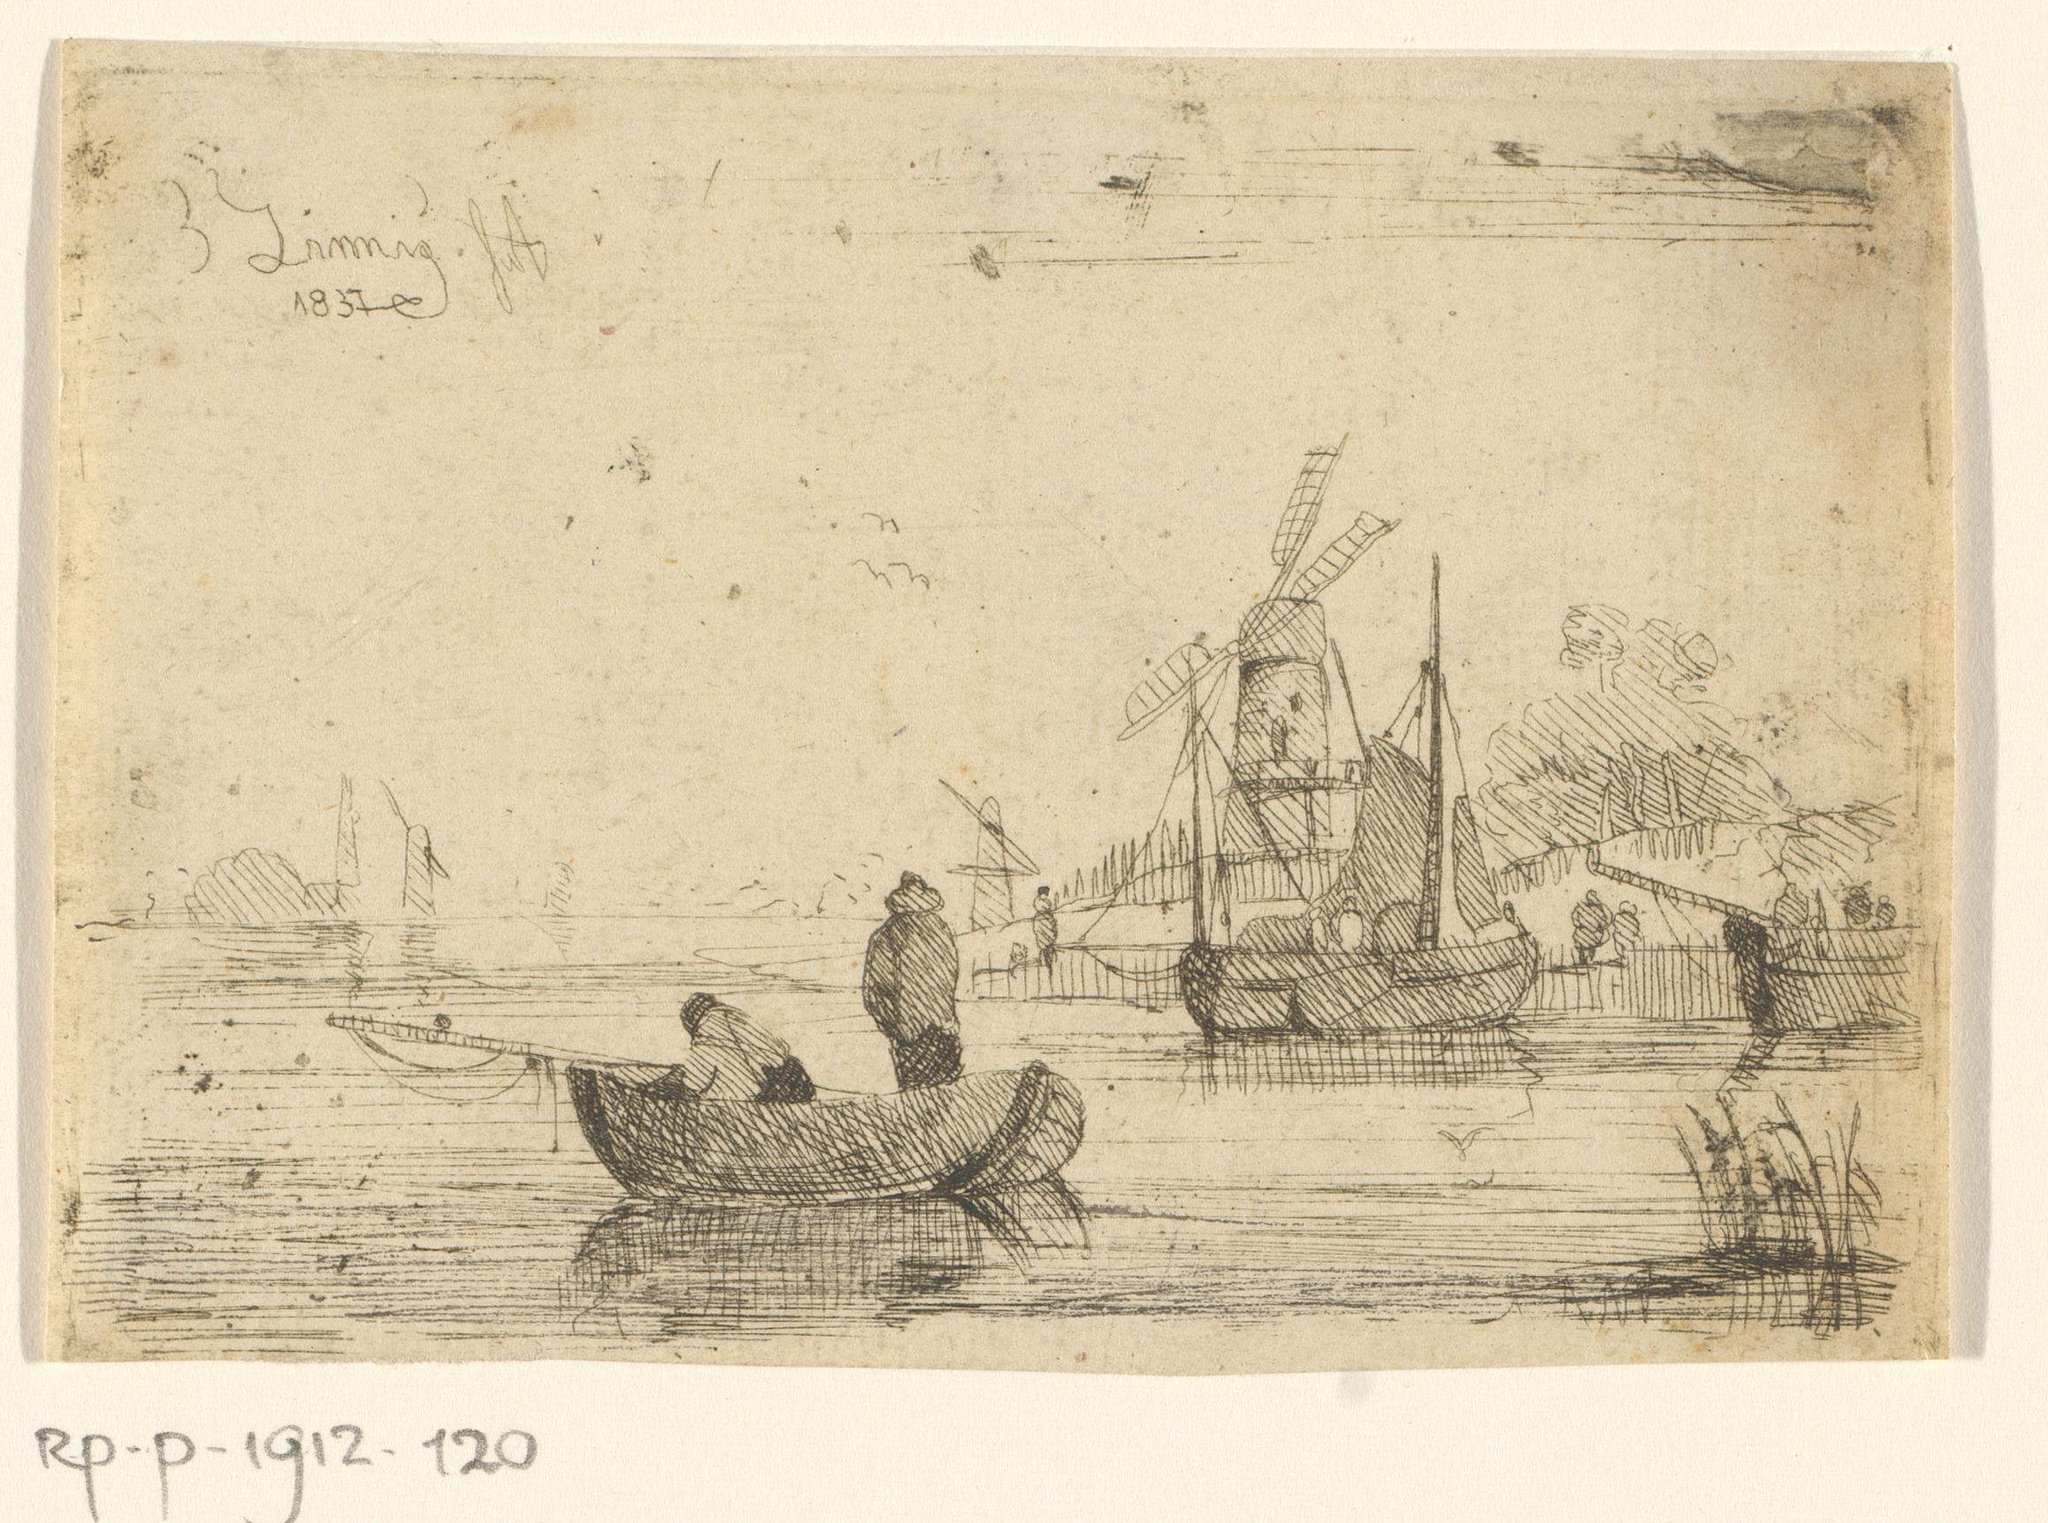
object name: print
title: Vissers in een roeiboot op open water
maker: egidius linnig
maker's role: draughtsman, print maker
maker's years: 1821-1860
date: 1837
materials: paper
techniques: etching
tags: rowing-boat, canoe, etc., angling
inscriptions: collector's mark: Lugt 2228, collector's mark: Lugt 1485